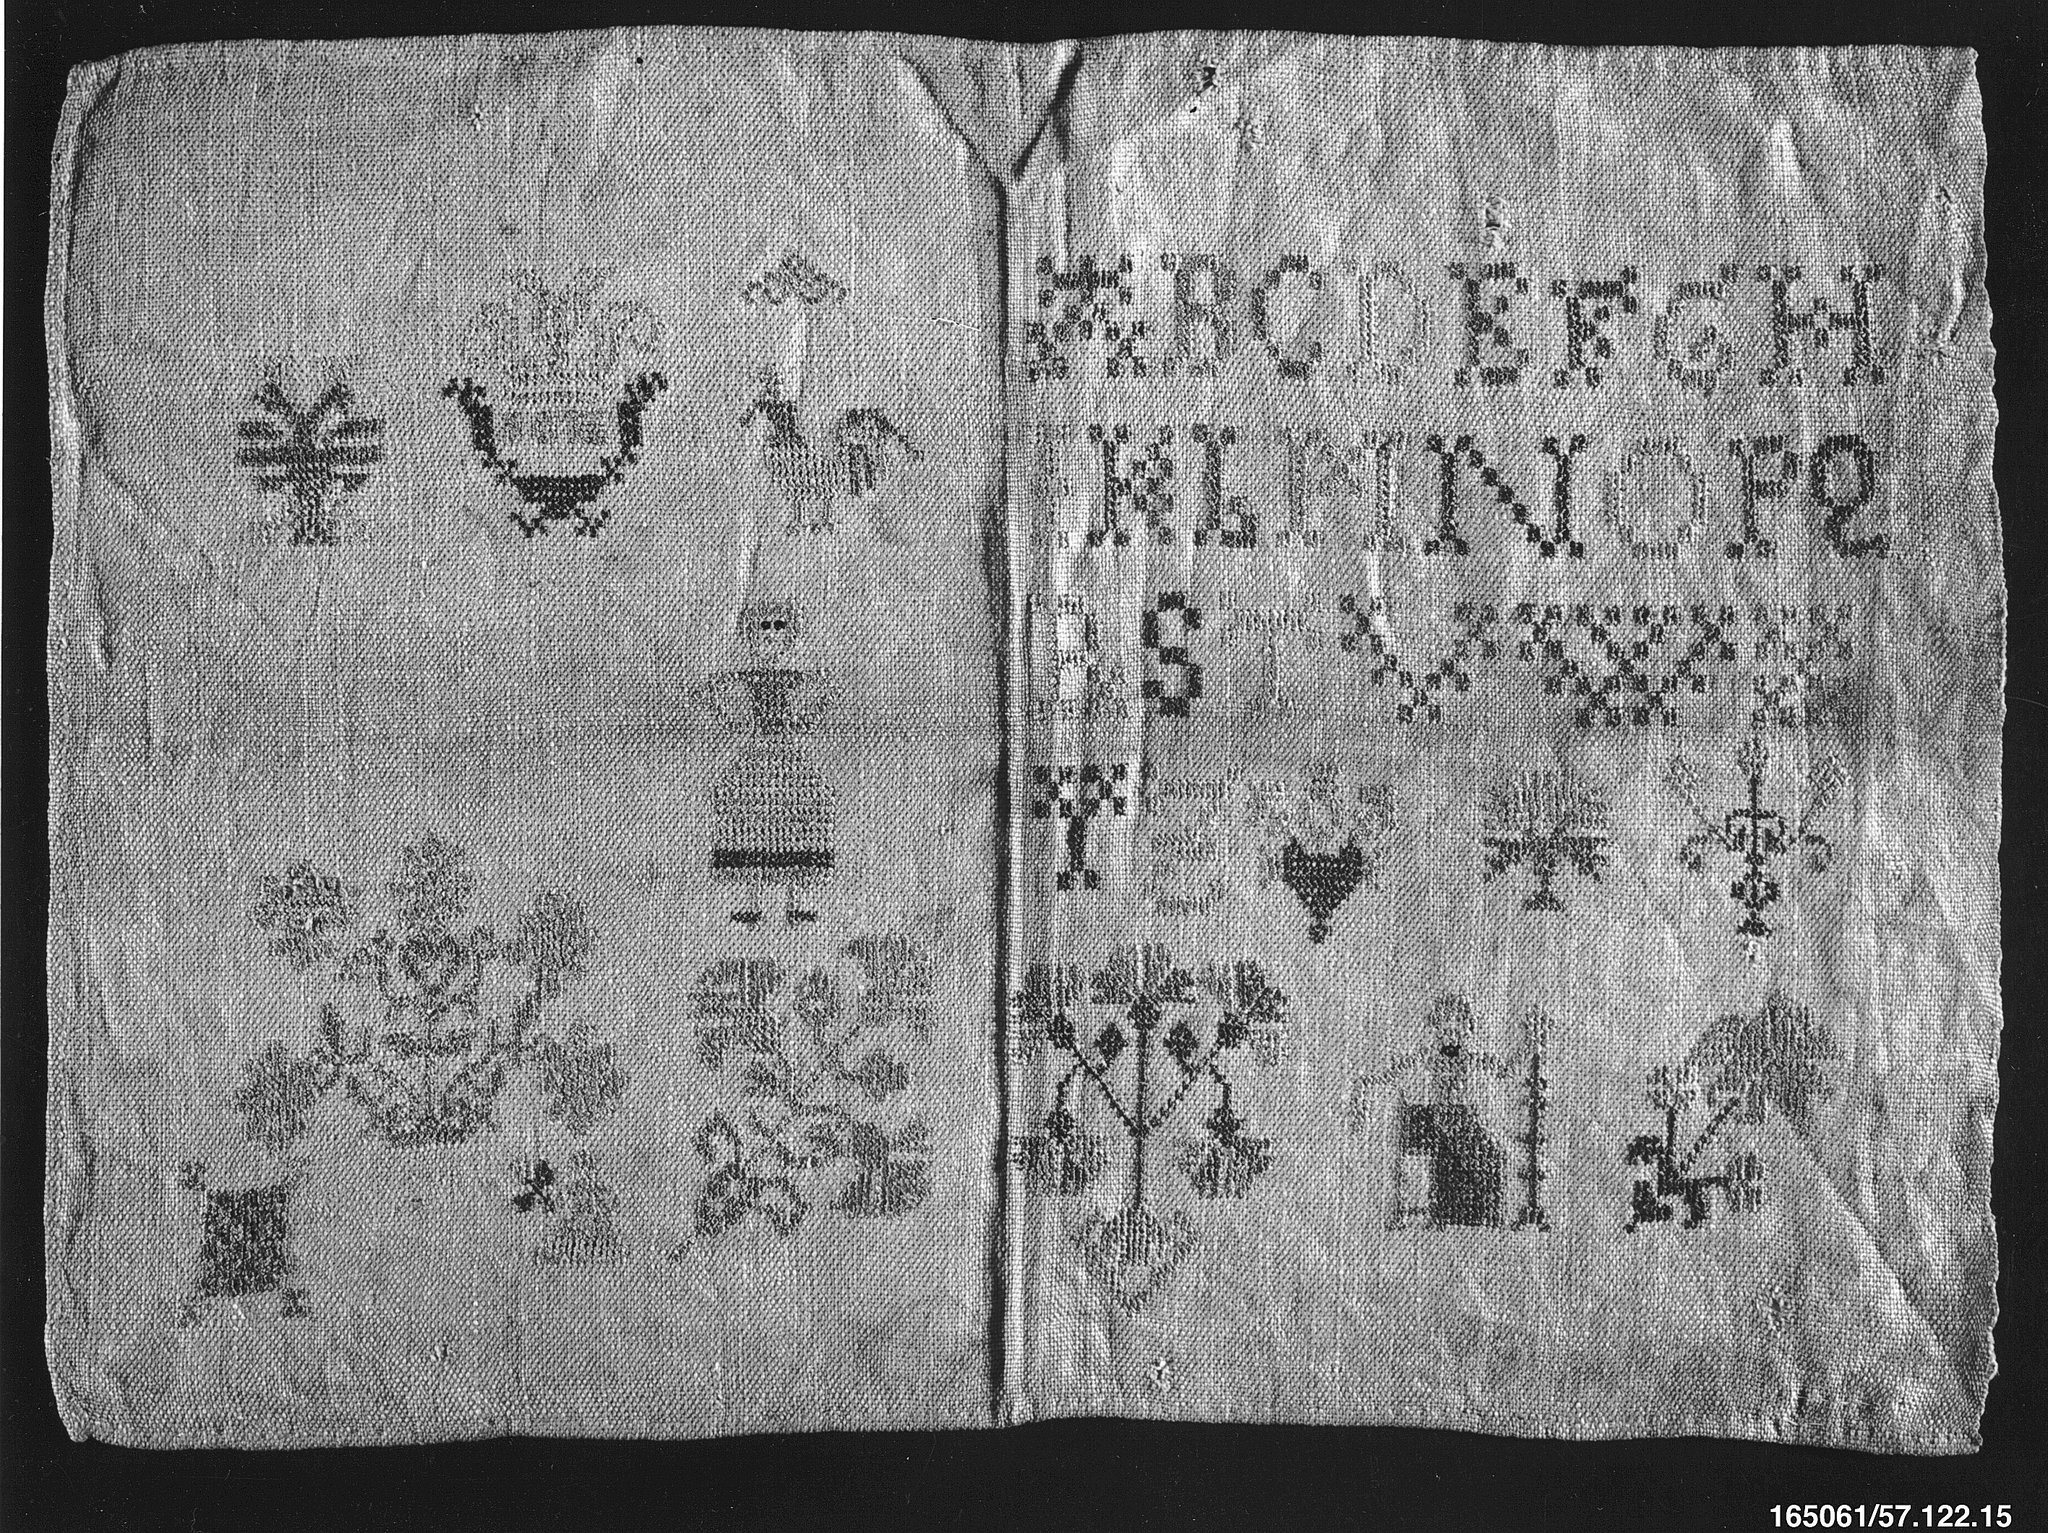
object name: sampler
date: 1701-1800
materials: linen, silk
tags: human figures